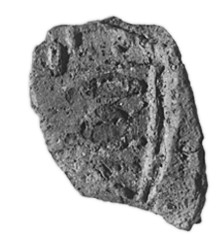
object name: sealing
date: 2030-1640 BCE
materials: clay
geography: egypt